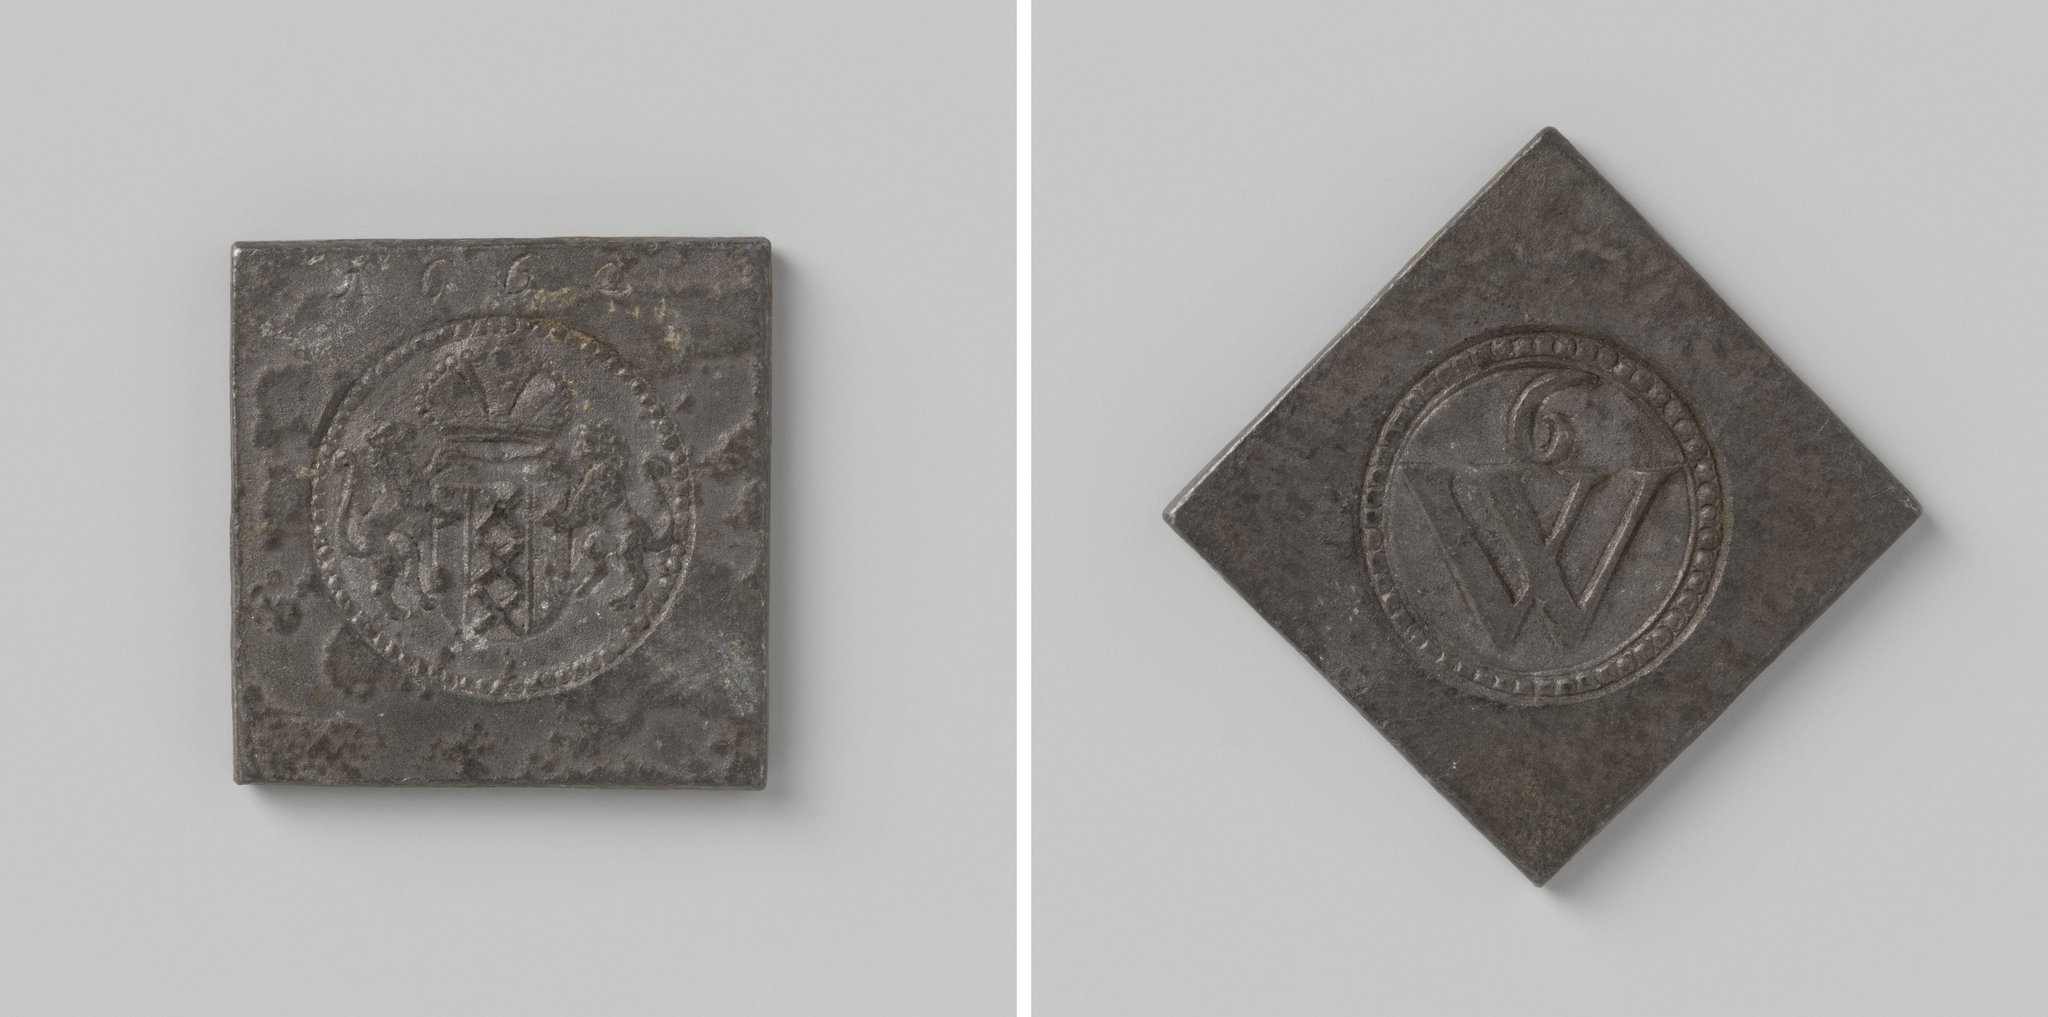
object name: alms token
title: Stad Amsterdam, wijk 6, armenpenning die recht gaf op roggebrood tegen een prijs van achteneenhalve stuiver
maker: Anonymous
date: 1662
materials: lead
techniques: casting, engraving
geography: amsterdam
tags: amsterdam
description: ruitvormig loodje. Voorzijde: in ronde stempel: gekroond wapenschild, geflankeerd door twee leeuwen binnen ronde parelrand; daarboven: jaartal. Keerzijde: in ronde stempel: cijfer 6 boven letter W binnen ronde parelrand